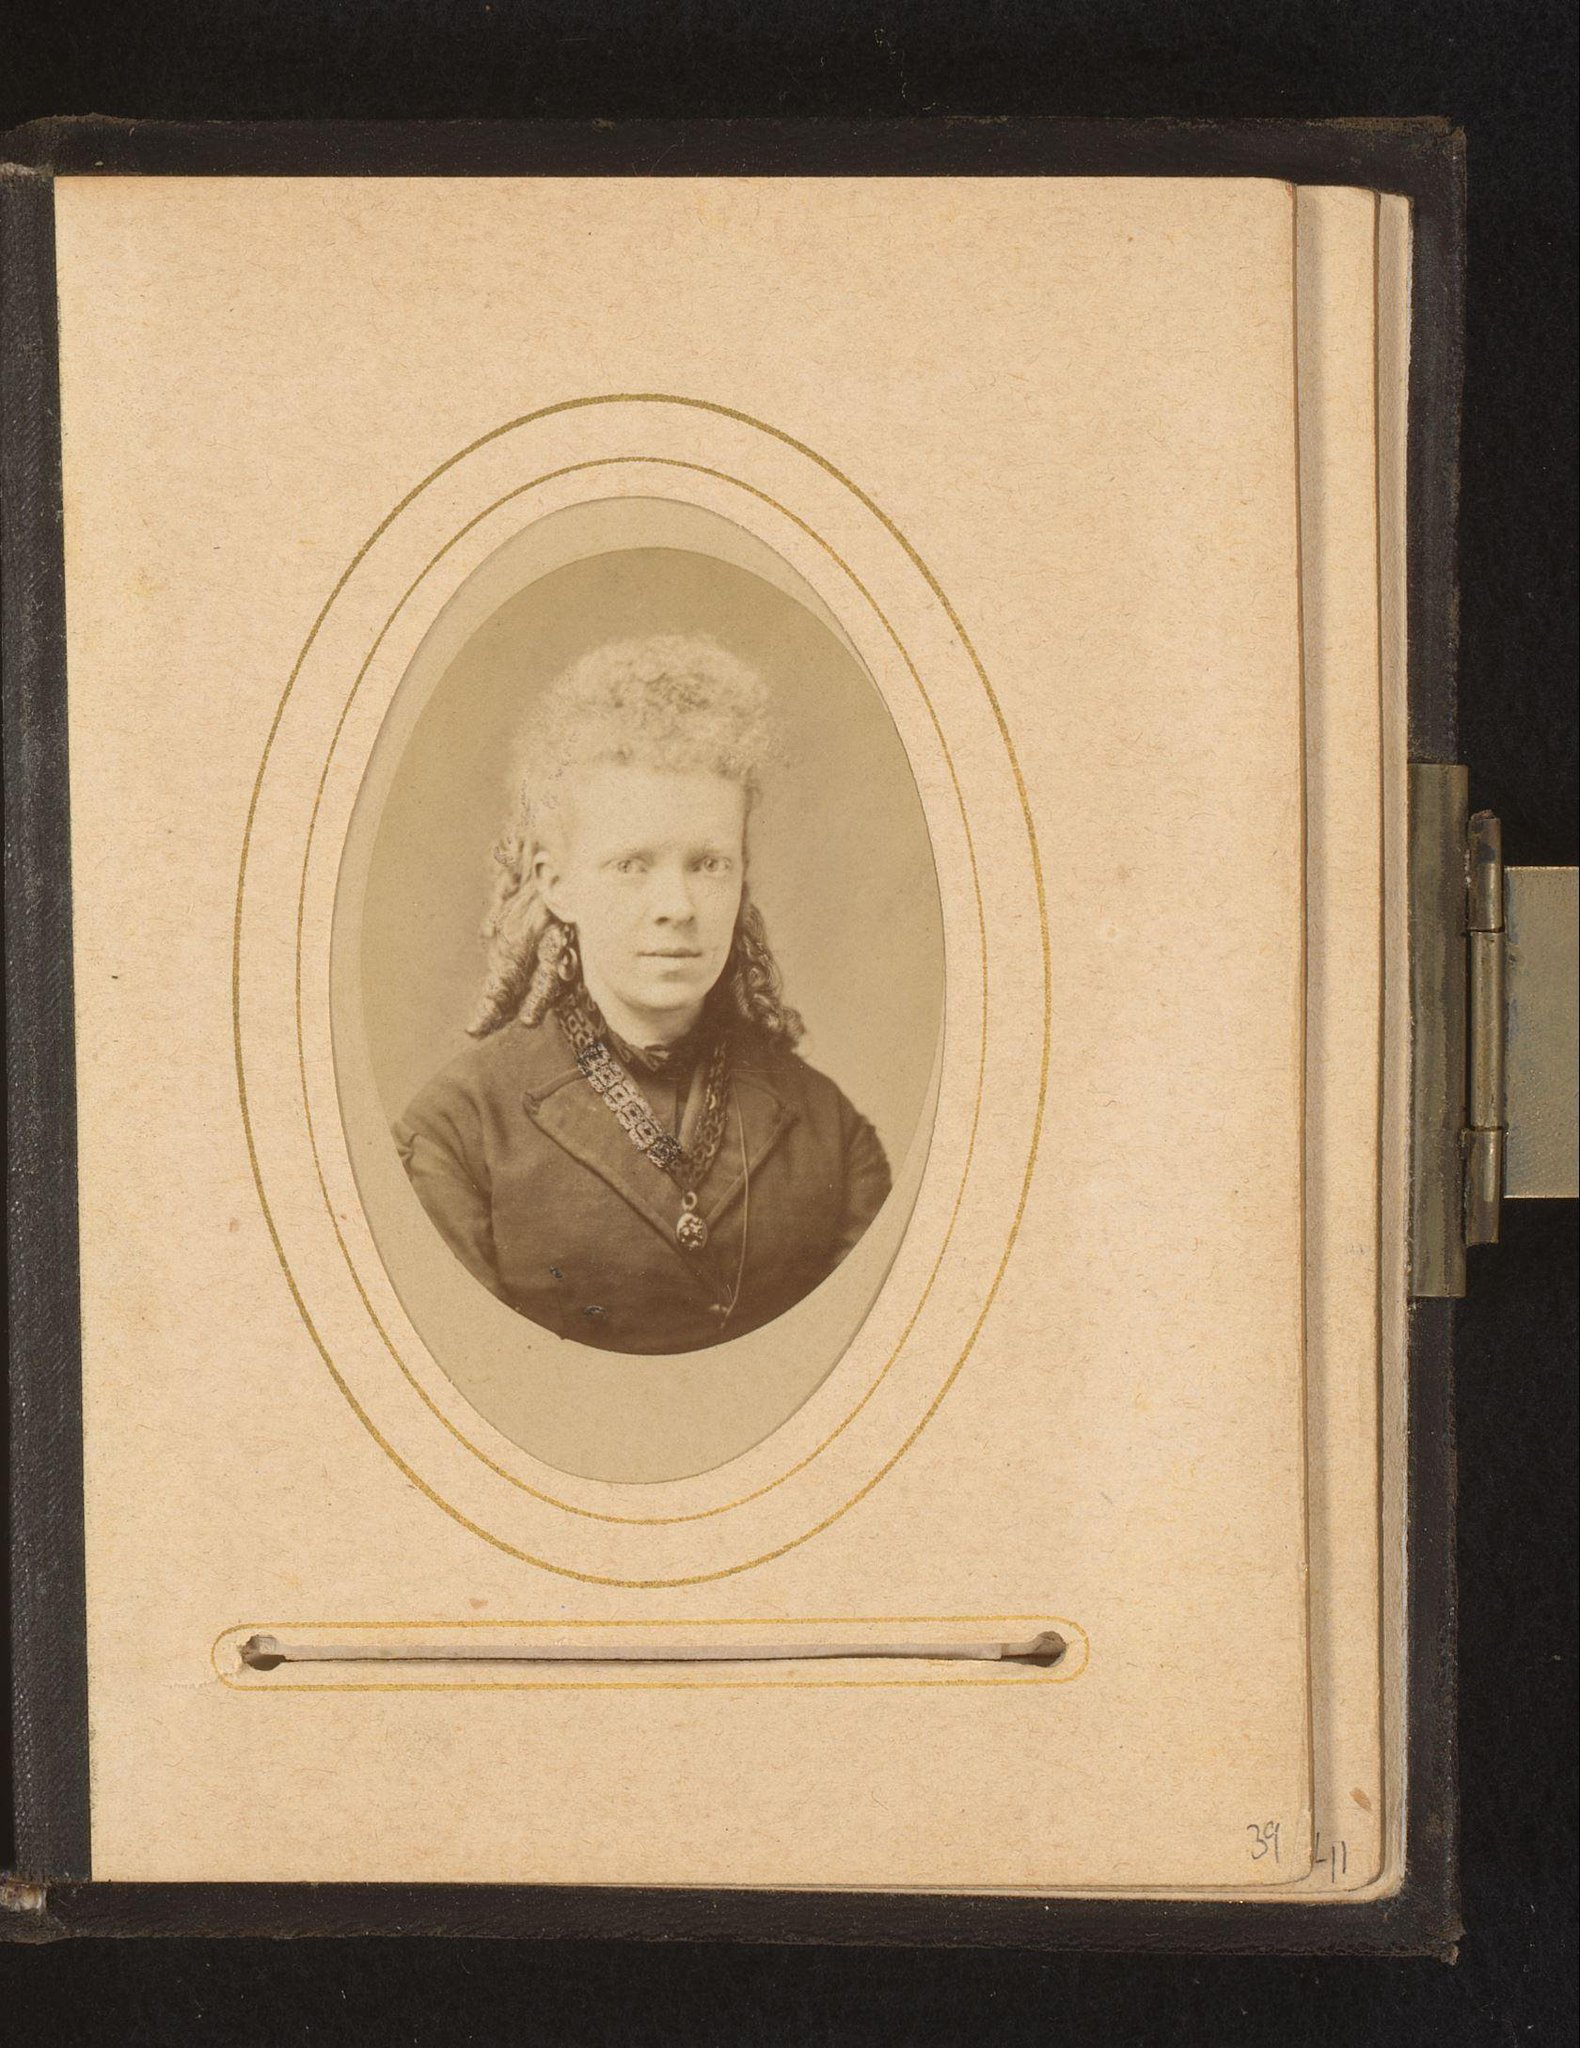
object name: carte de visite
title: Portret van een vrouw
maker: jan george mulder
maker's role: fotograaf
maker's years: 1816-1895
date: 1865-1887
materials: cardboard, photographic support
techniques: albumen print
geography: haarlem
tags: historical persons - bb - woman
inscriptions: inscription: ‘Photogr. Atelier/ J.G. Mulder/ Lange Bagijnestraat/ over de Israëlitische Kerk/ Haarlem’